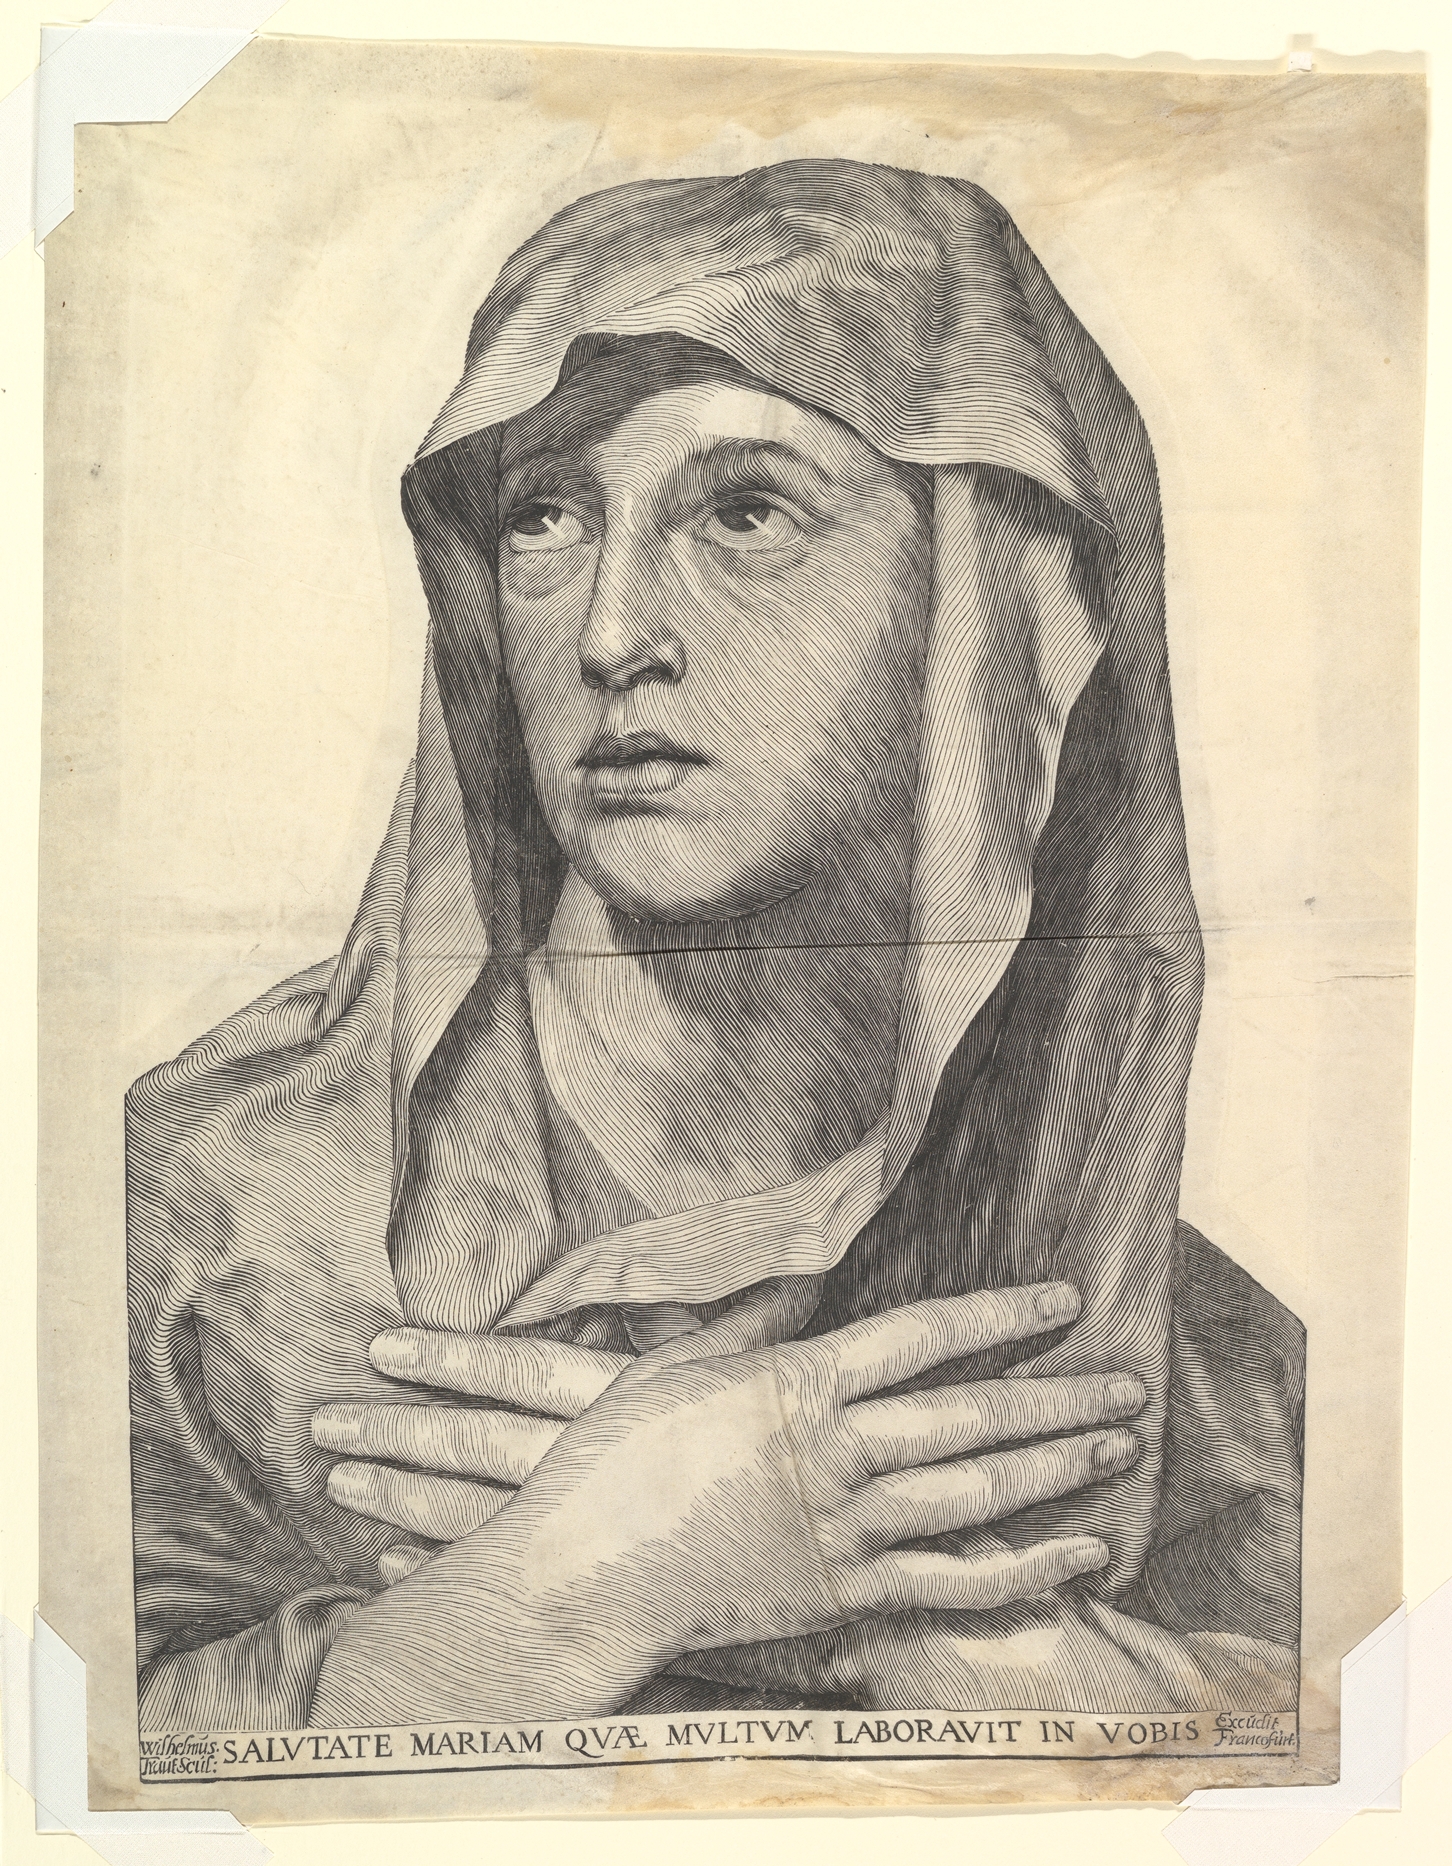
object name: print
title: Bust of Mary with Crossed Hands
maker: wilhelm traut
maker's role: artist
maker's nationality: german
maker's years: 1650-1662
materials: parchment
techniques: woodcut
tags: virgin mary